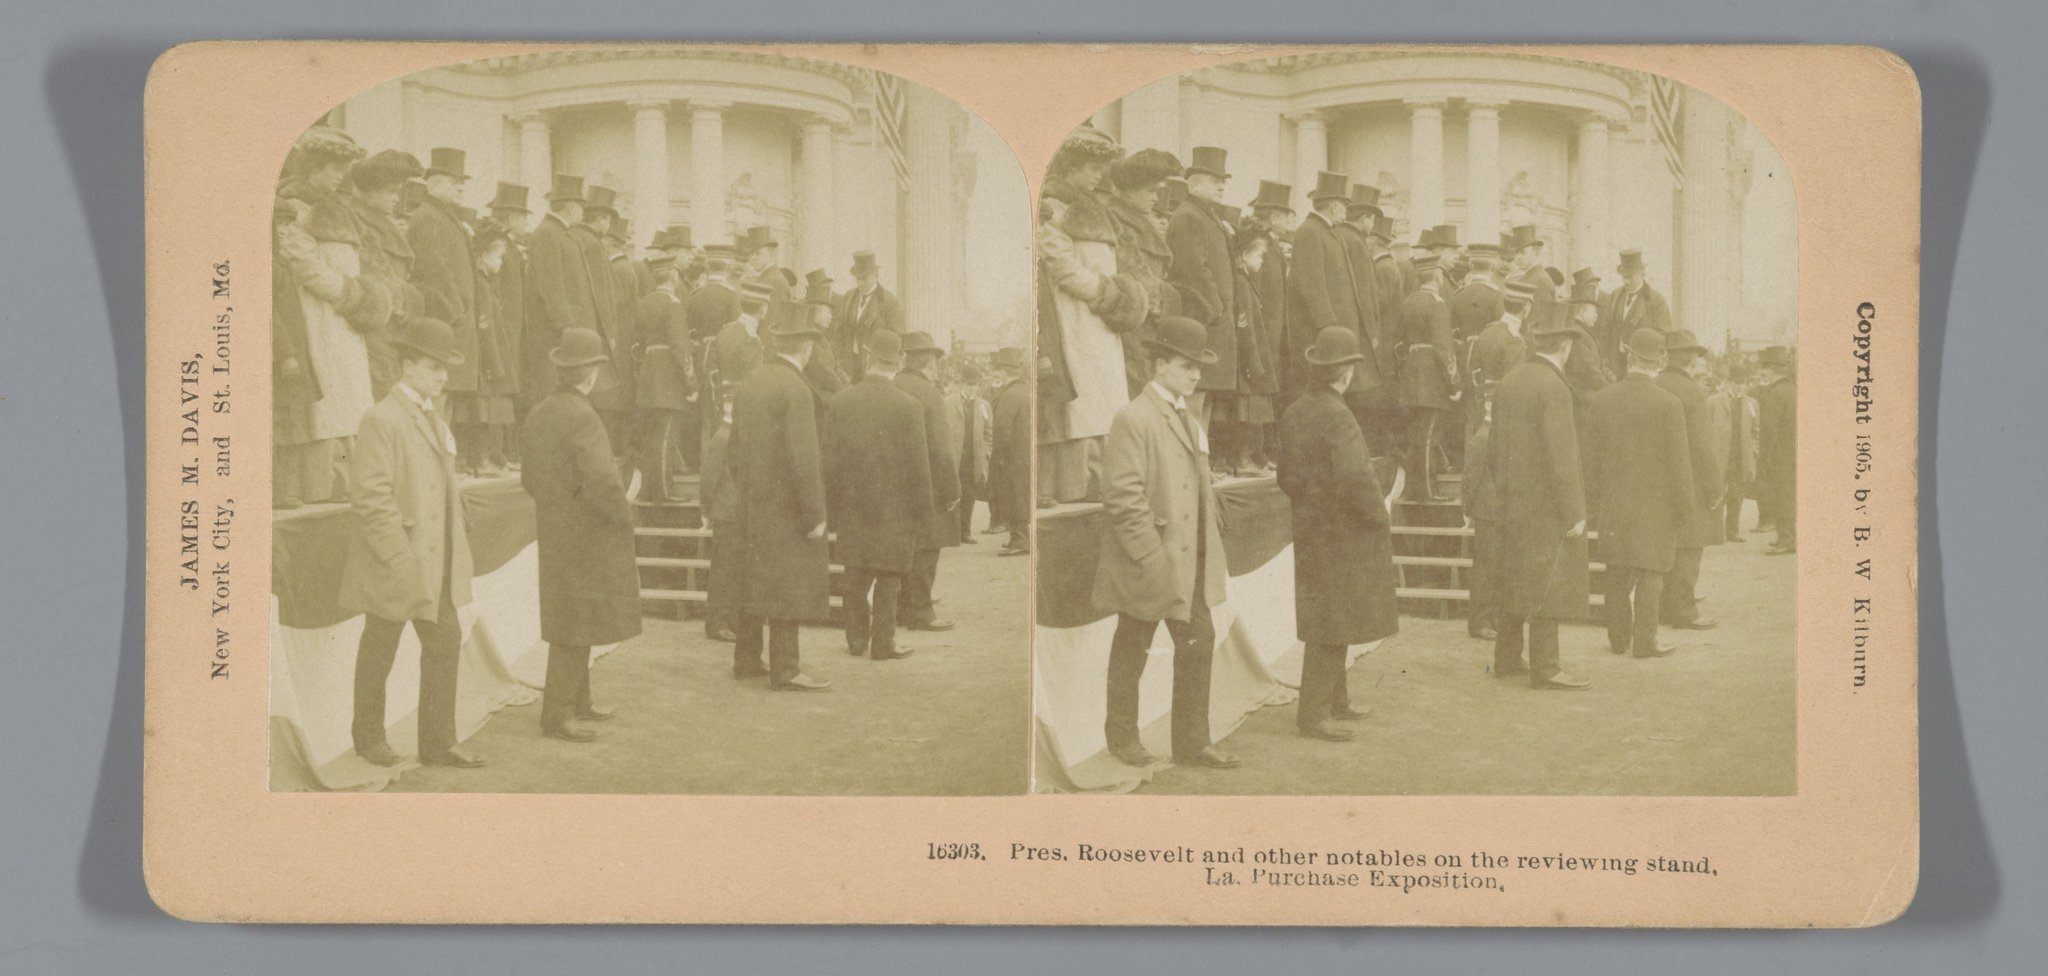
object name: stereograph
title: President Roosevelt bezoekt de Wereldtentoonstelling van 1904 in Saint Louis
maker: benjamin west kilburn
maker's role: fotograaf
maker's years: 1827-1909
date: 1904-1905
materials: cardboard, paper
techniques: albumen print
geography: littleton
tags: meeting, assembly, world fair, world exhibition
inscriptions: number: ‘16303.’, copyright notice: ‘Copyright 1905, by B.W. Kilburn.’